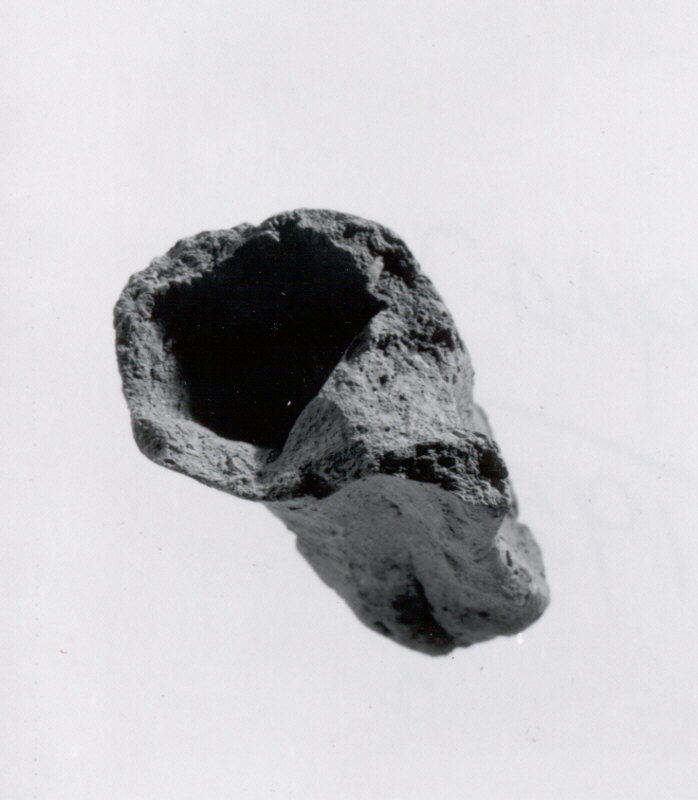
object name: sculpture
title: Fragment of animal figurine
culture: edomite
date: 800-601 BCE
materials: ceramic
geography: levant